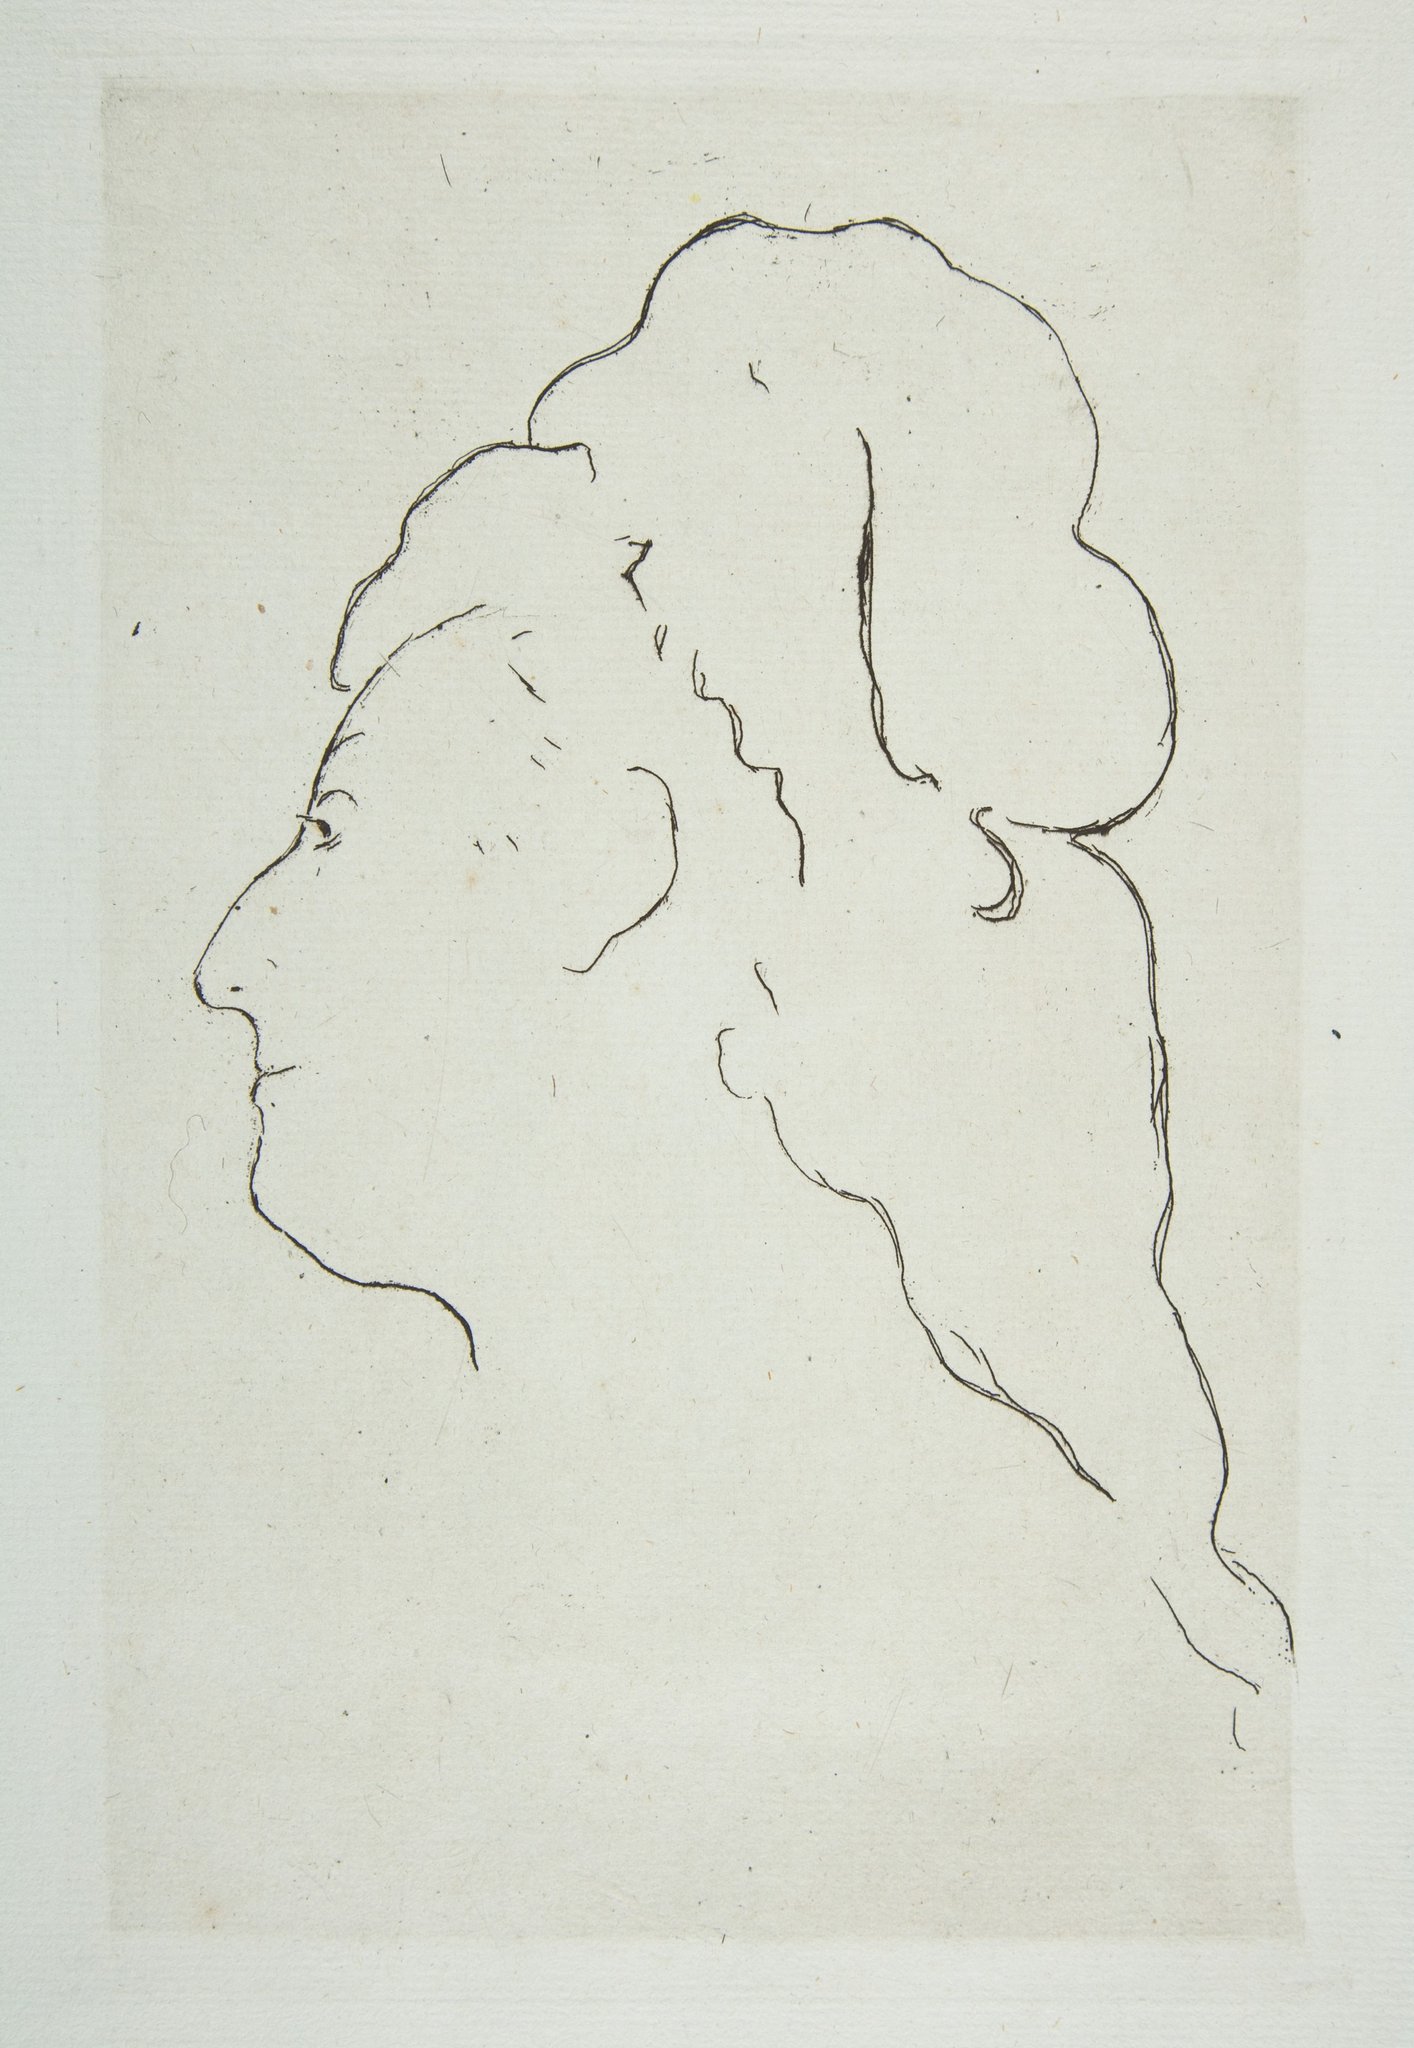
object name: print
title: Profile of Eva Gonzalès turned to the left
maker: édouard manet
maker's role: artist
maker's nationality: french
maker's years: 1832-1883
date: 1870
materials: paper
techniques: etching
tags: profiles,women